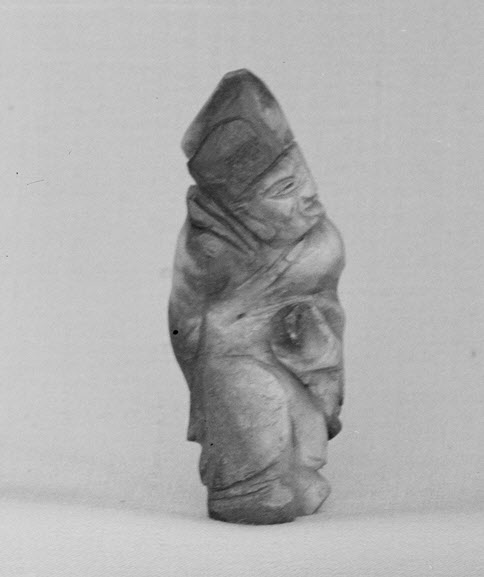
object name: ornament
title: Standing figures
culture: chinese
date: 1368-1644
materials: jade